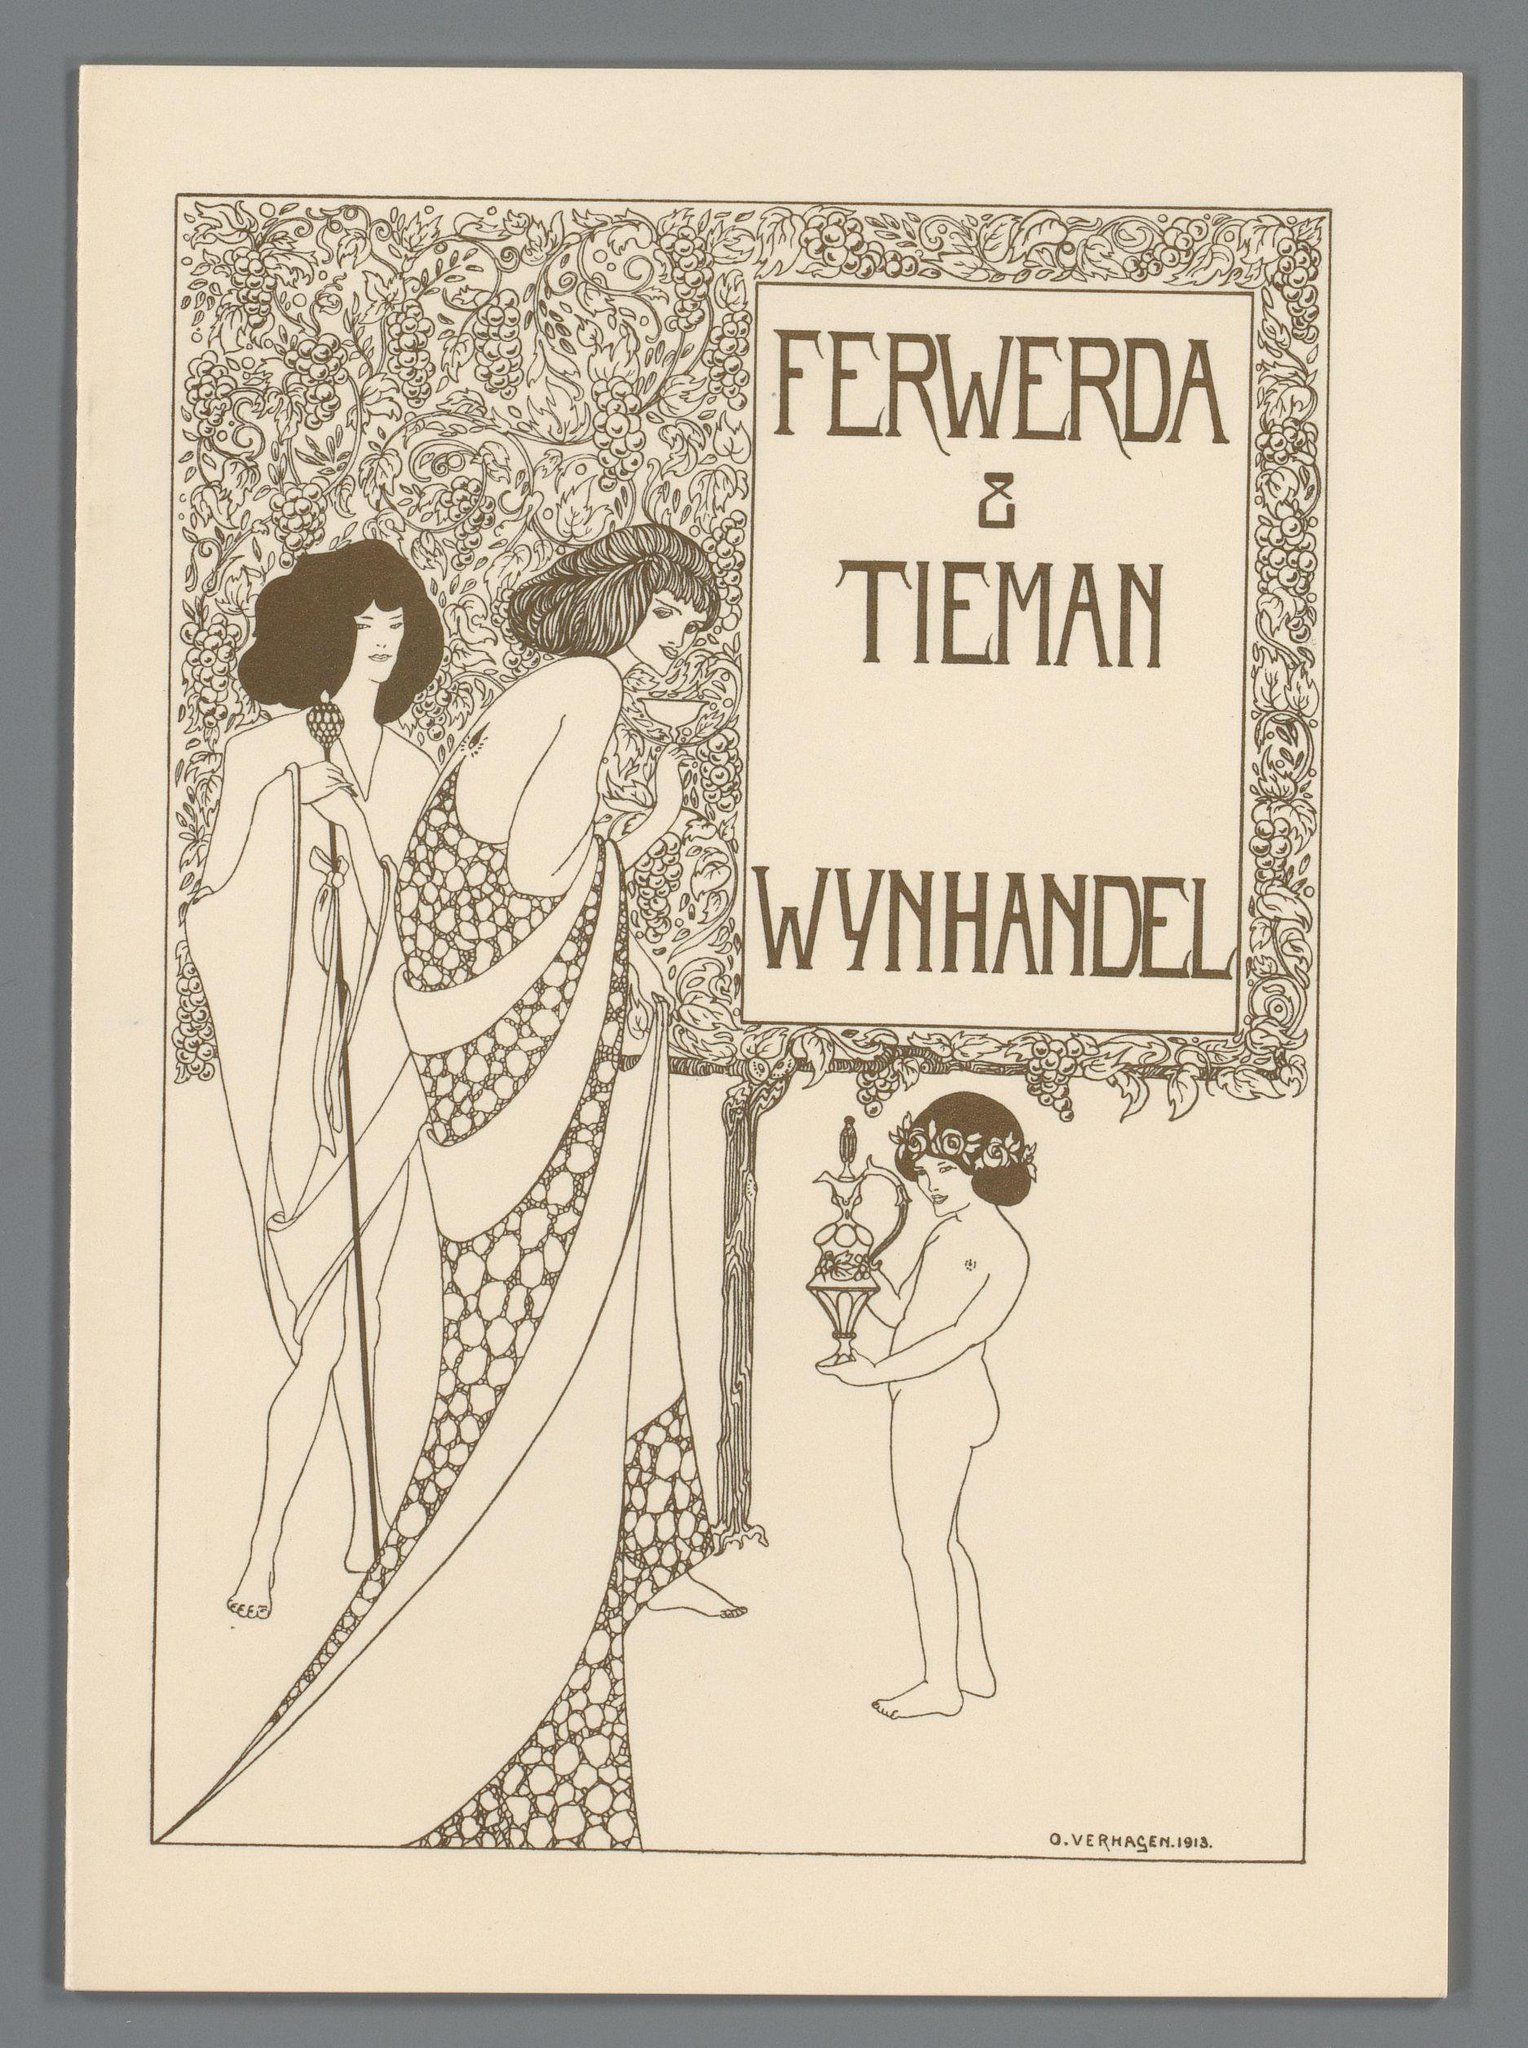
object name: print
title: Prijscourant van Ferwerda & Tieman Wijnhandelaren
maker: otto verhagen (i)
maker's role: draughtsman, print maker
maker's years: 1885-1951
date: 1913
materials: paper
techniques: lithograph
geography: amsterdam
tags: shop, store, advertising, viticulture, wine-growing; vintage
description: Reclamefolder van Wijnhandel Ferwerda & Tieman, Da Costakade te Amsterdam. Boekje met prijslijsten, op de voorzijde een illustratie van twee vrouwen en een kind met een karaf tegen een achtergrond van wijnranken.